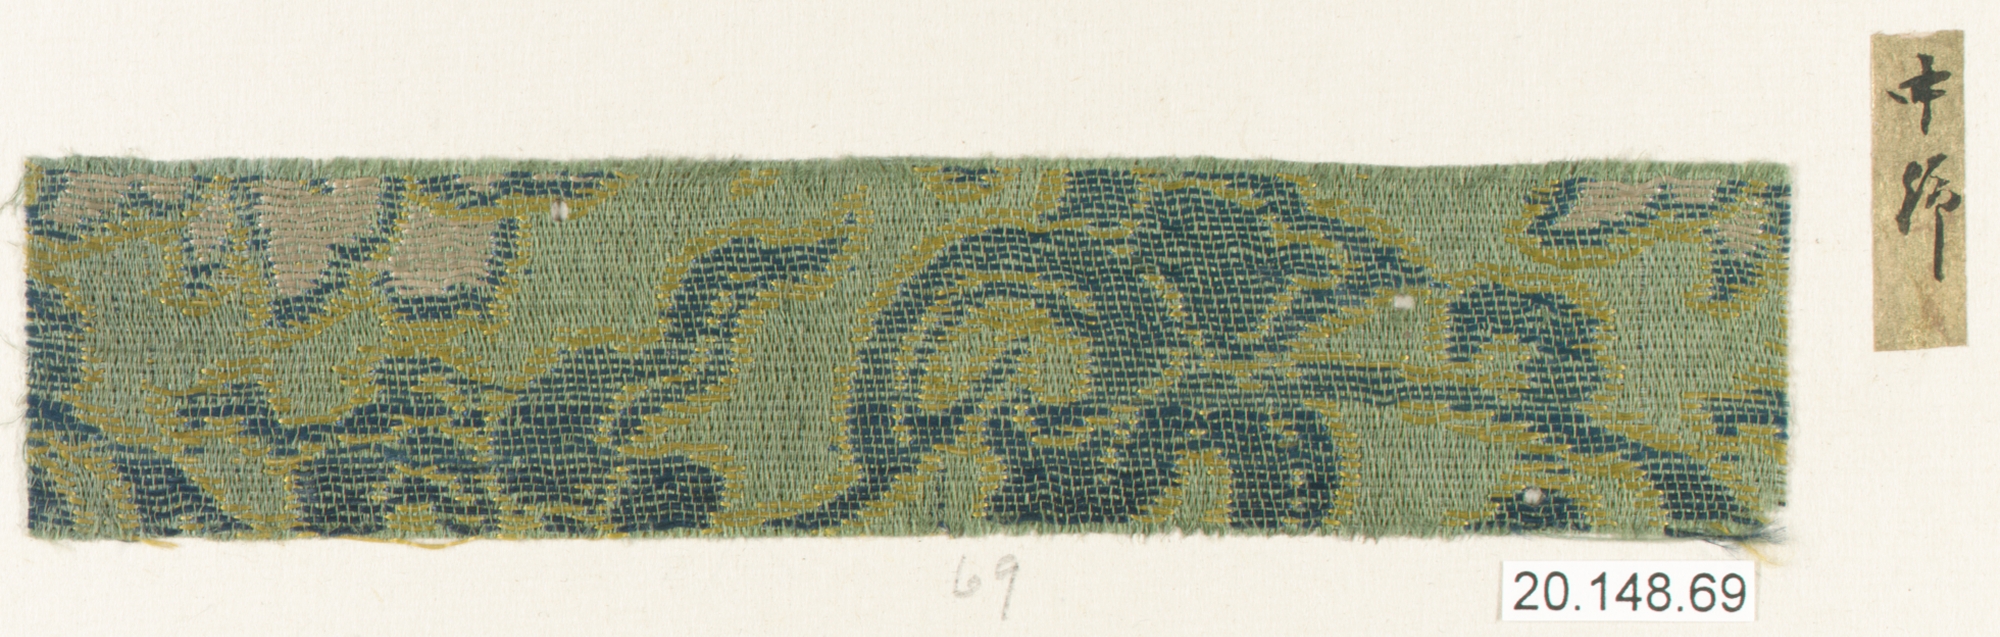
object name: piece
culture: chinese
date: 1601-1700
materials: silk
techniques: compound weave